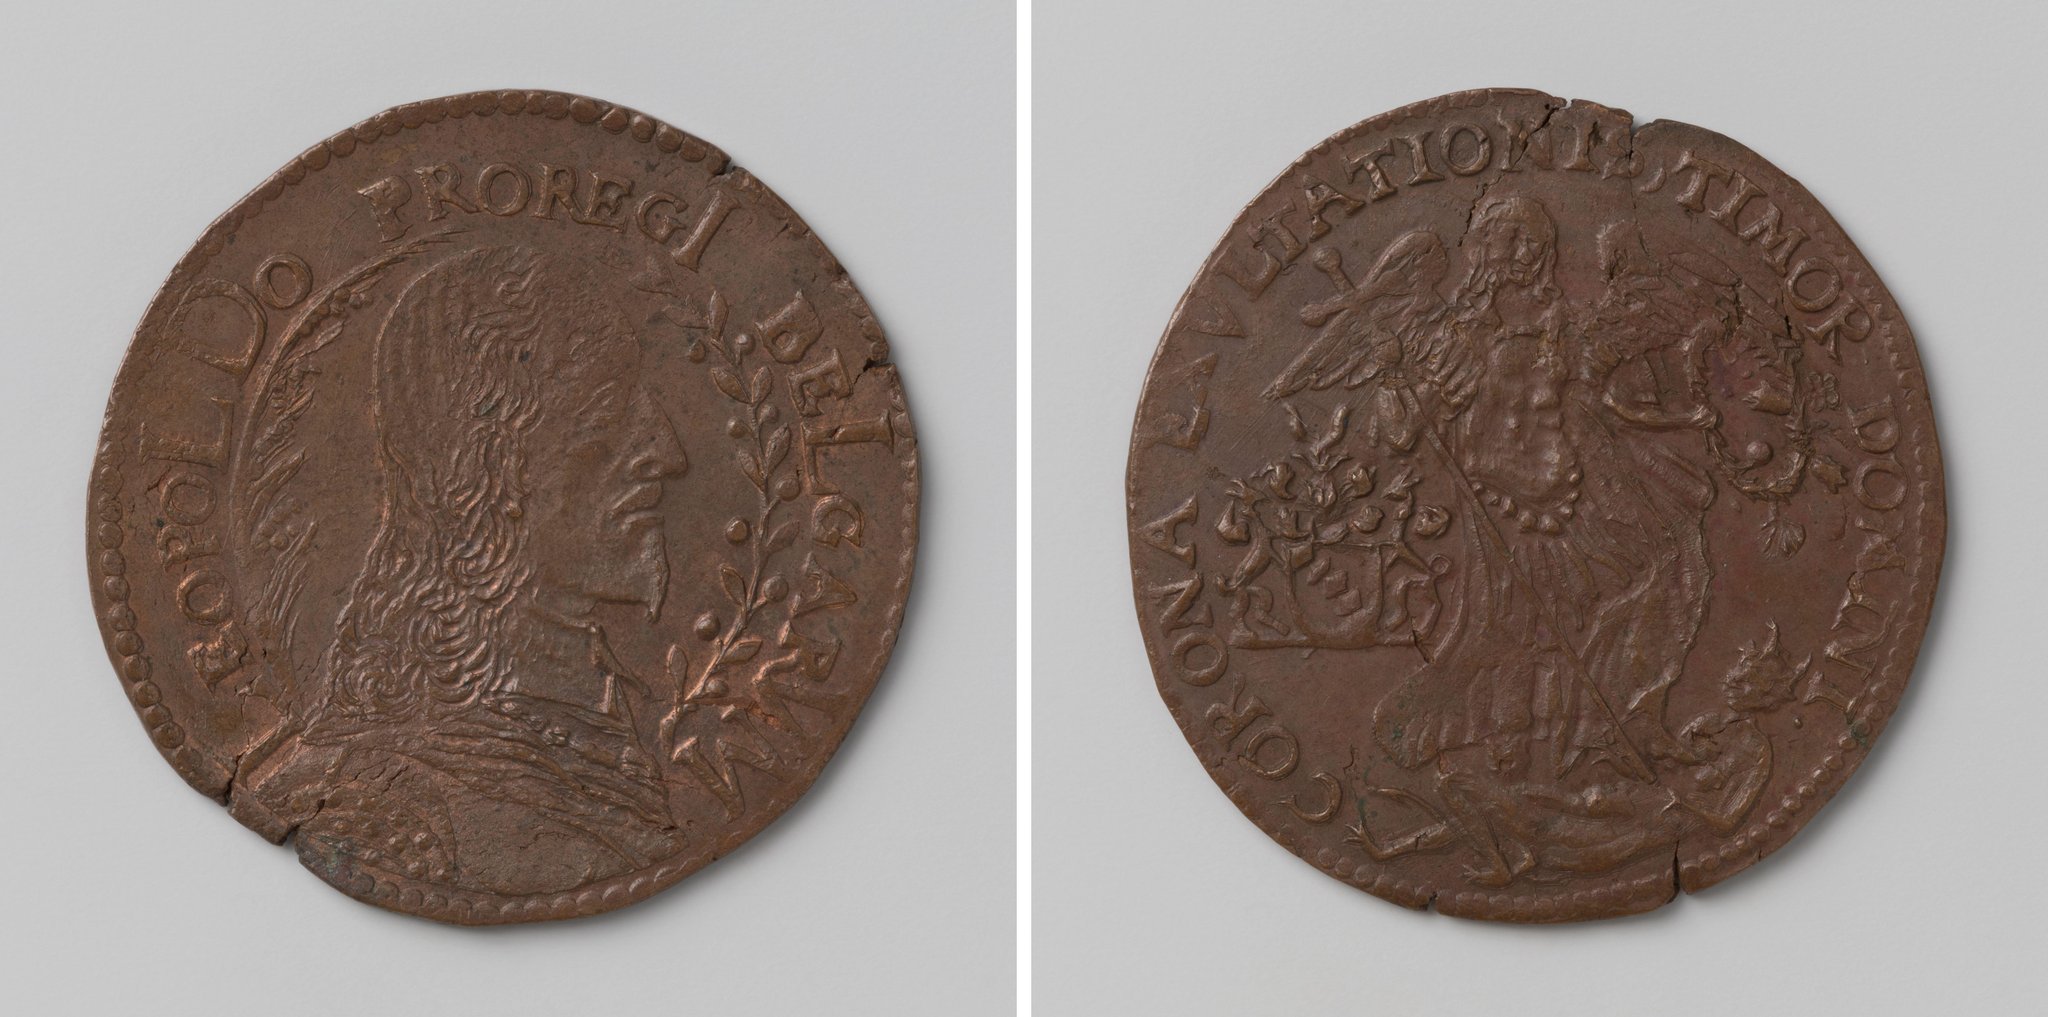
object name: jeton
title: Vertrek van Leopold Willem, aartshertog van Oostenrijk, uit de zuidelijke Nederlanden, rekenpenning van Frederik de Marselaer, magistraat van de schatkist van Brussel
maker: Anonymous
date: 1601-1656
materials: copper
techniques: striking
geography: belgium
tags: vienna, leopold willem van oostenrijk (landvoogd der zuidelijke nederlanden), albert casimir van saksen-teschen, southern netherlands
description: Koperen penning. Voorzijde: borststuk man tussen lauwer- en palmtak binnen omschrift. Keerzijde: aartsengel Michael met kruis en krans in handen, staande op ter aarde liggende draak; rechts: gehelmd wapenschild, geflankeerd door twee honden binnen omschrift